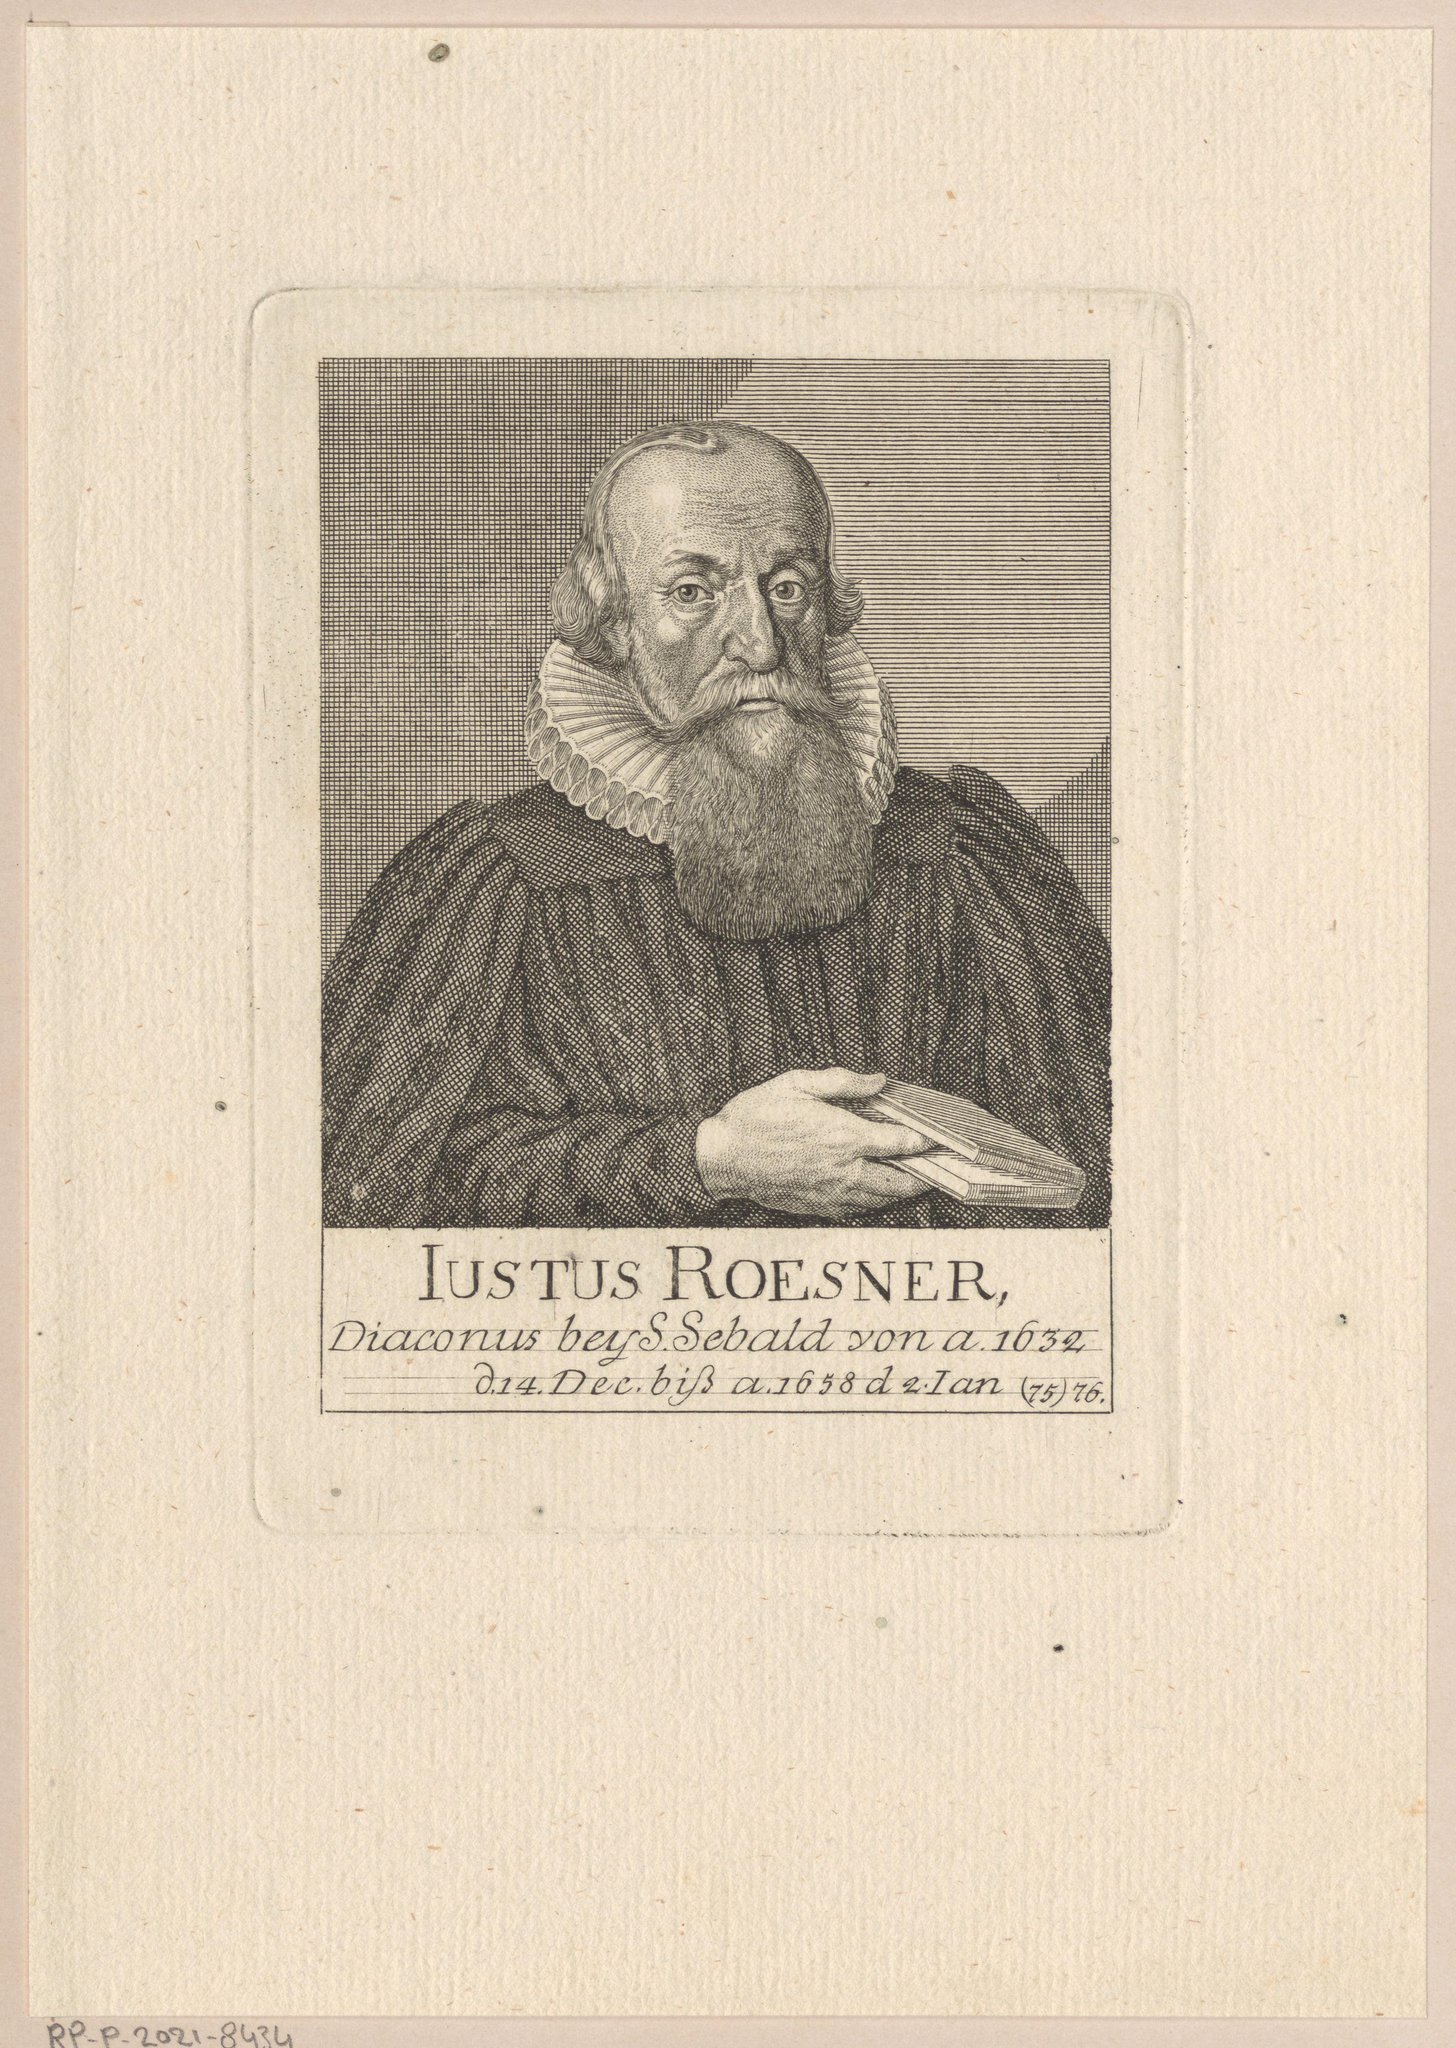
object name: print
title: Portret van Justus Rösner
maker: christoph melchior roth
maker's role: print maker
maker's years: 1720-1798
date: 1756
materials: paper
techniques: engraving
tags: historical persons, book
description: Prent mogelijk uit: Würfel, Andreas. Diptycha ecclesiae Sebaldianae (...). Neurenberg: Christoph Melchior Roth, 1756.